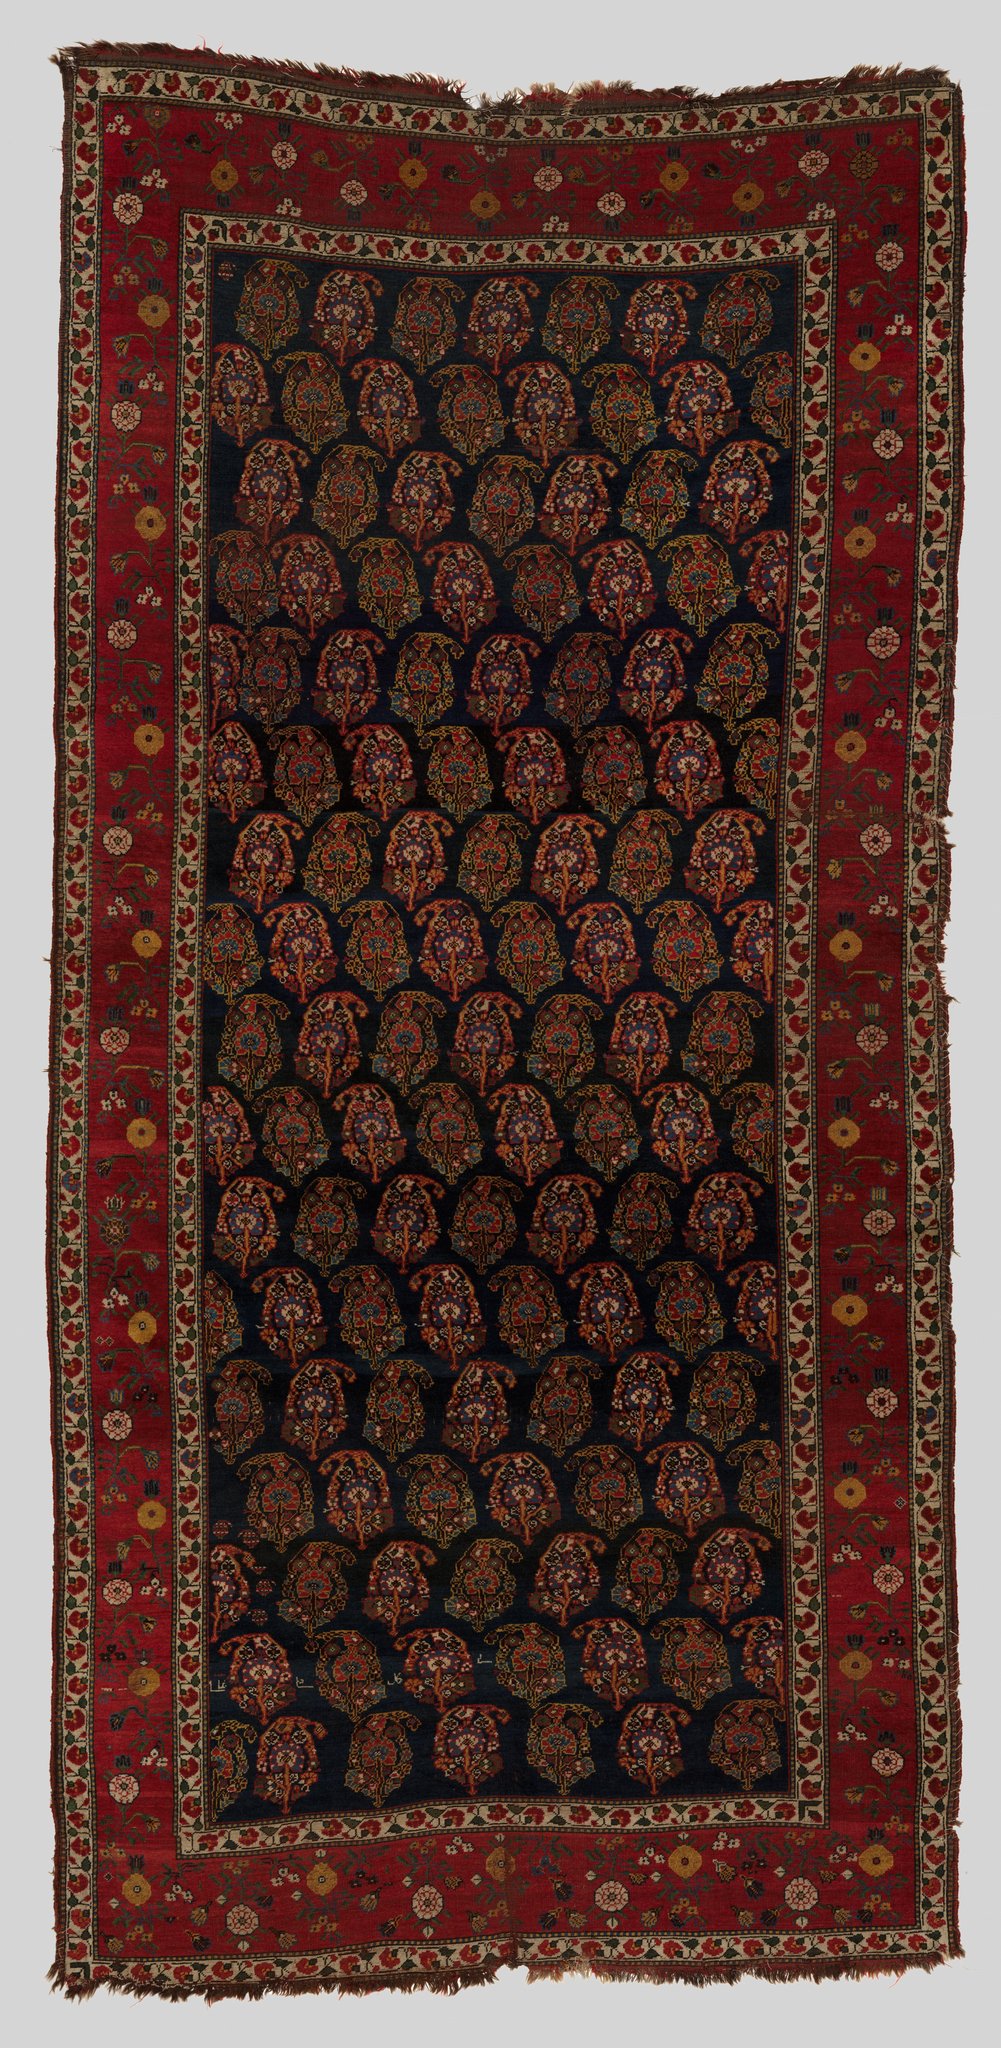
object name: oriental rug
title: Oosters tapijt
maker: quli ghani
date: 1800-1900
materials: wool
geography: south persia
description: Oosters tapijt van geknoopte wol waarvan het middenveld versierd is met rijen boteh's samengesteld uit kleurige bloemen en bladeren, tegen een blauw fond. Drie randen waarvan de middelste versierd is met bloemen. Moeilijk leesbare inscriptie, vertaald als de signatuur van een Quashghai wever: "het werk van Quli Ghani".